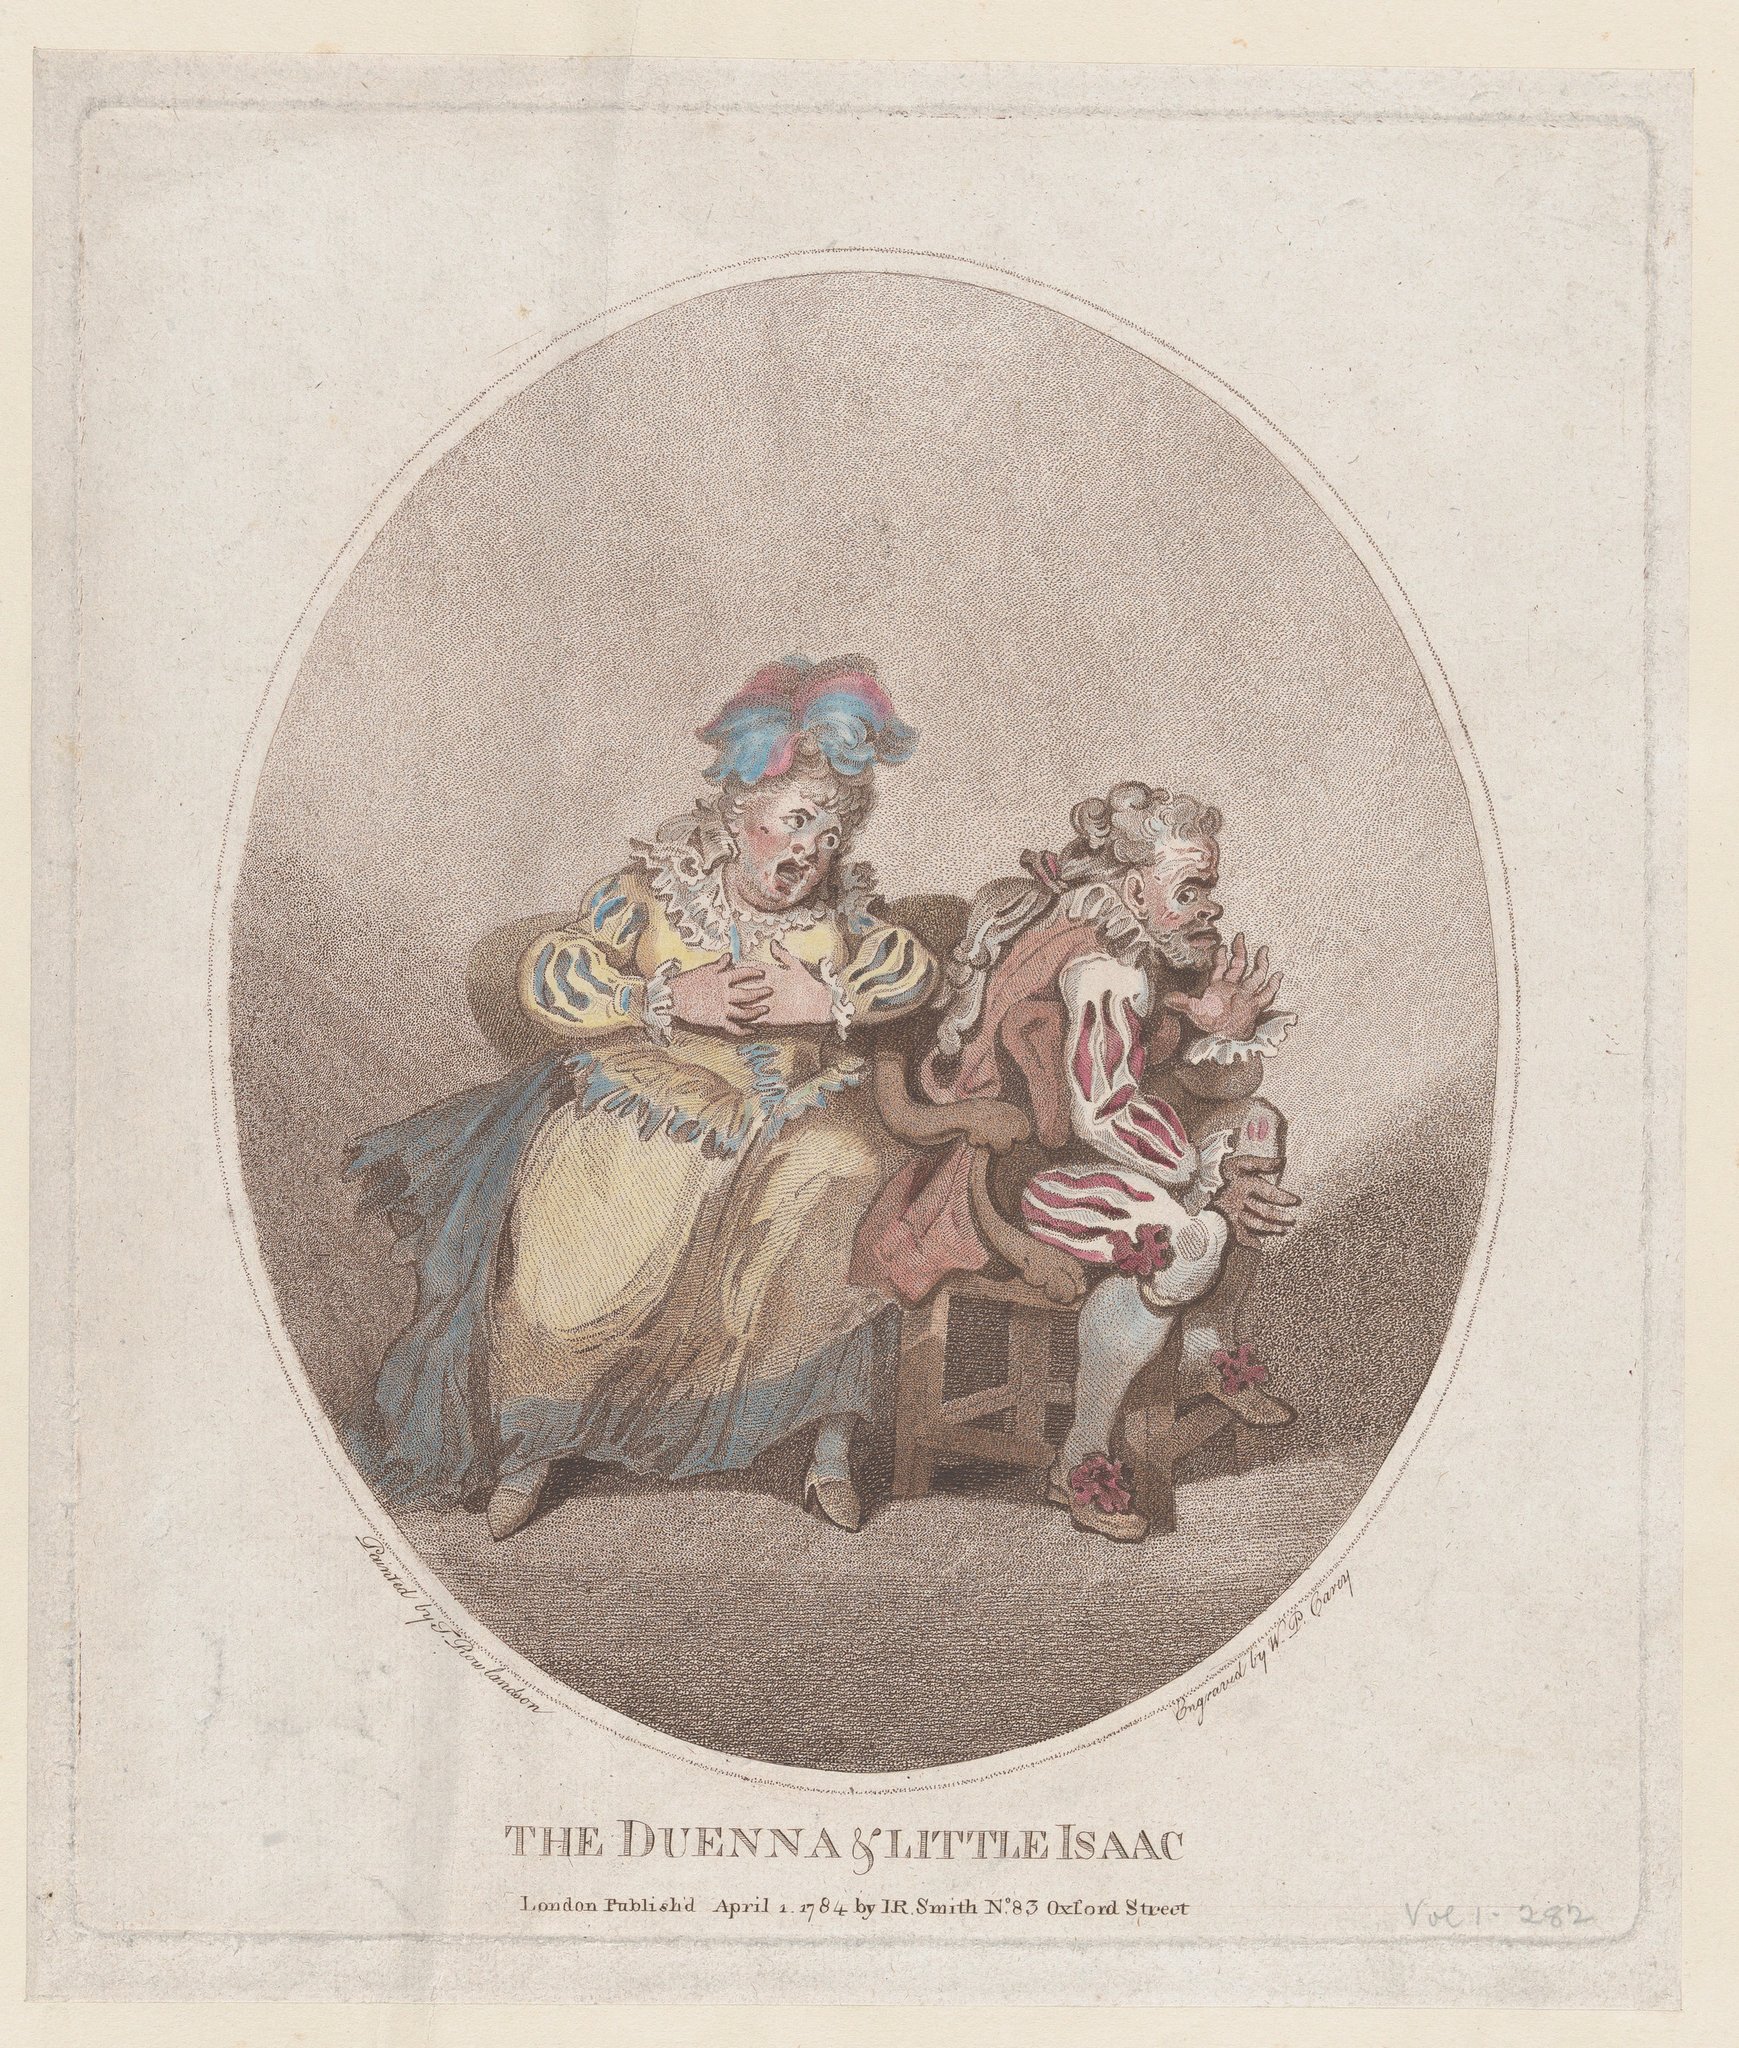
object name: print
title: The Duenna & Little Isaac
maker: william paulet carey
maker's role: artist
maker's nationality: irish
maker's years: 1759-1839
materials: ink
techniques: hand coloring, printing, engraving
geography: london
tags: men,women